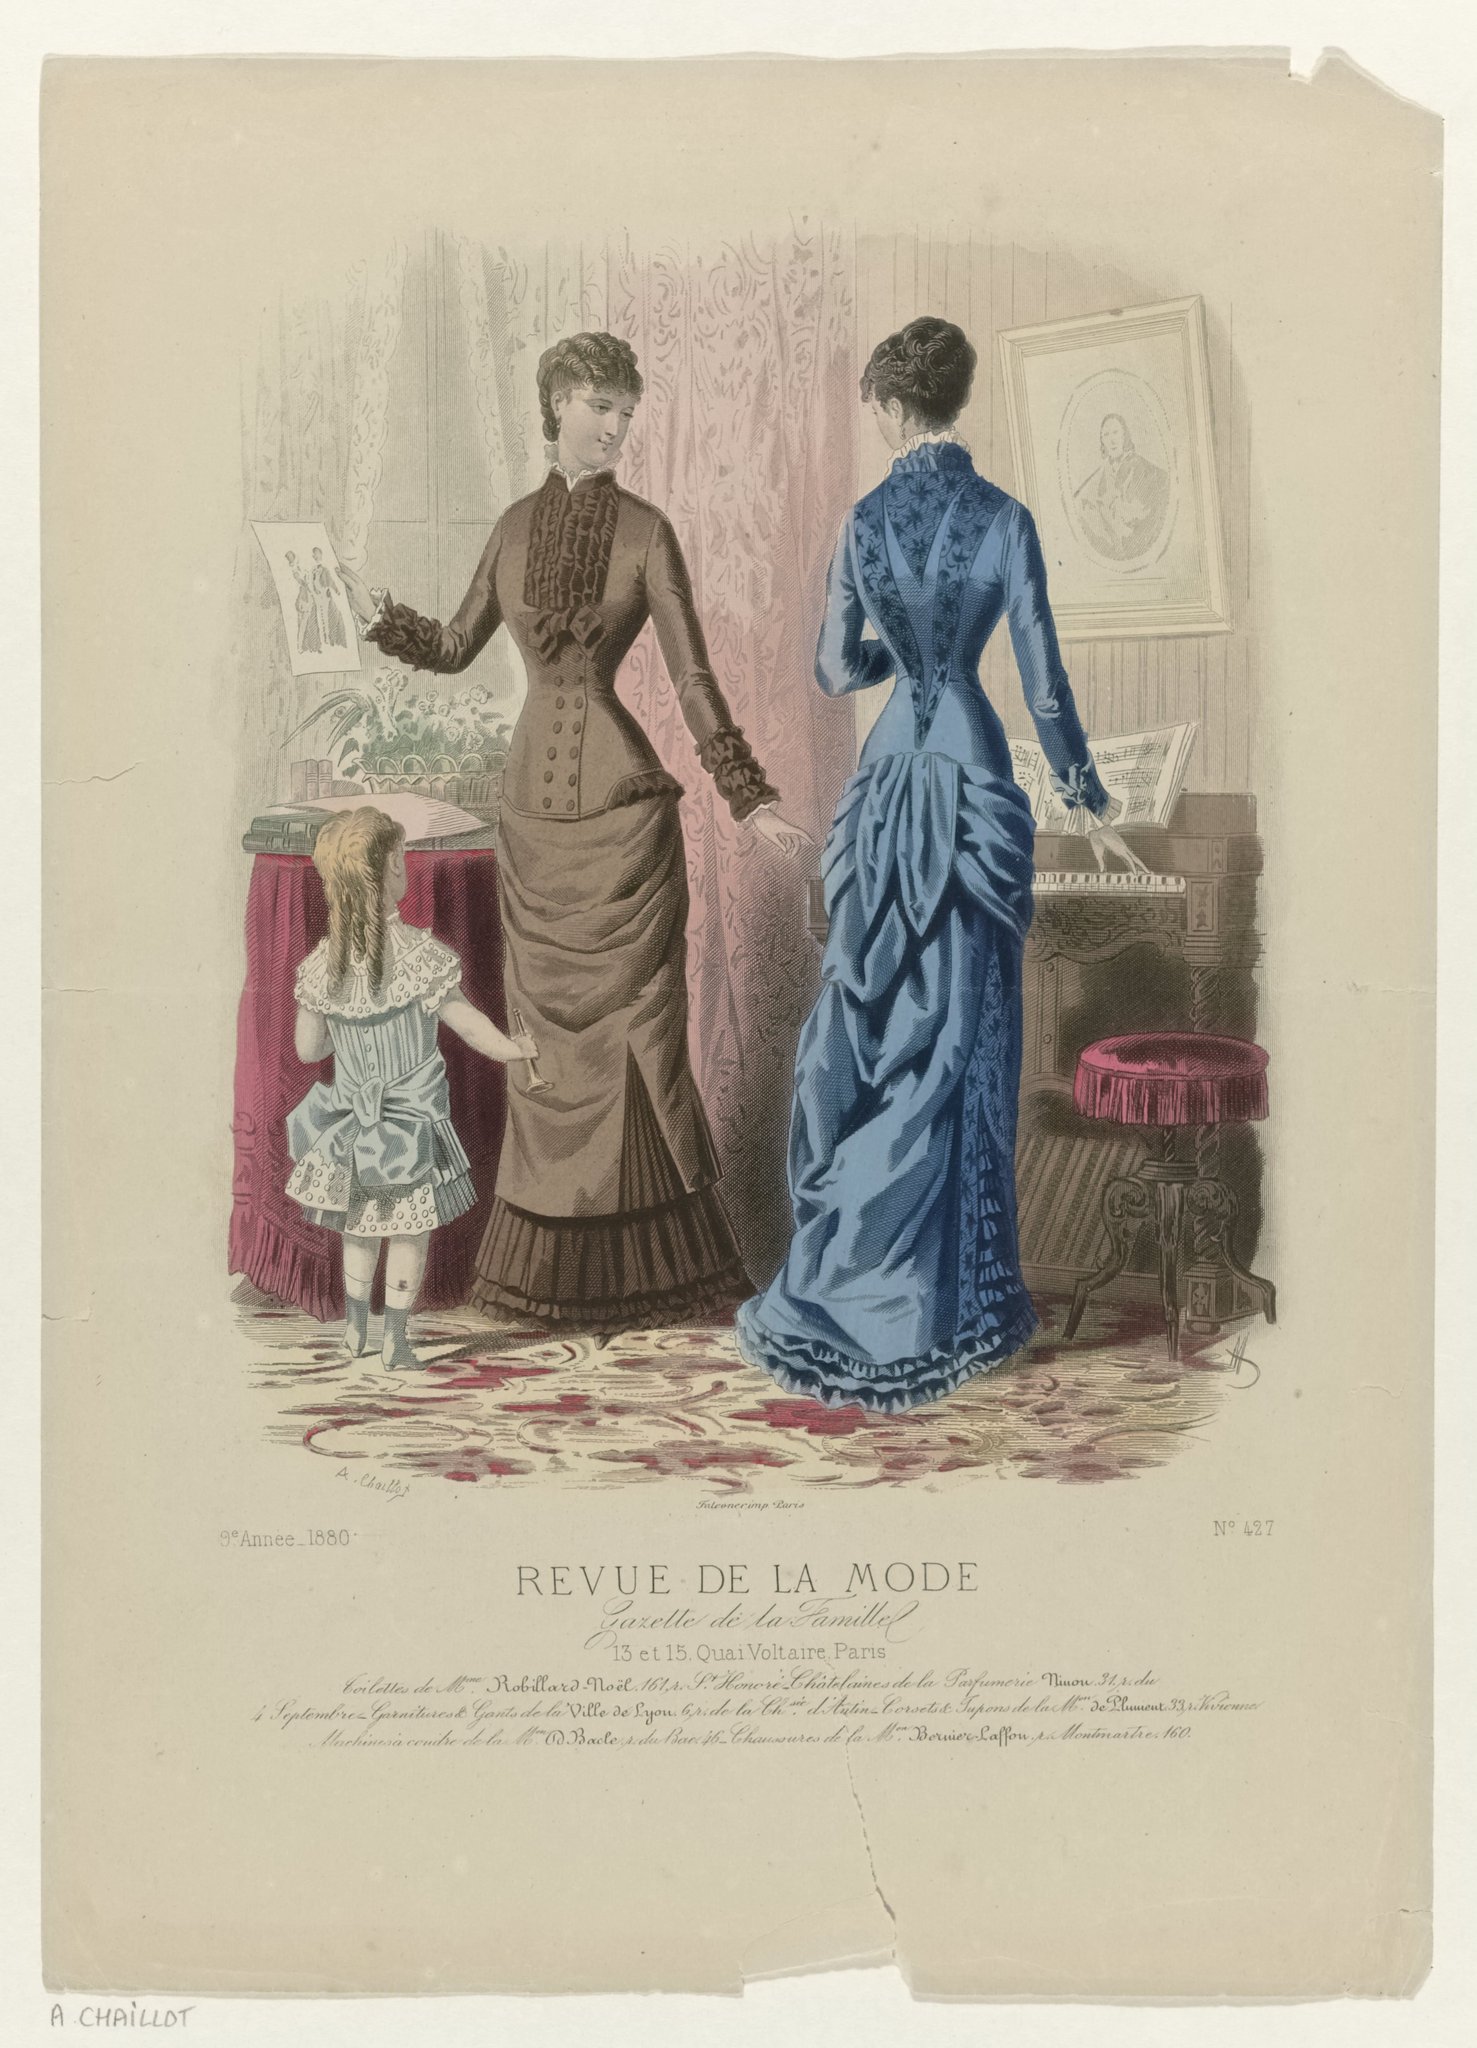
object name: fashion print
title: Revue de la Mode, Gazette de la Famille, dimanche 7 mars 1880, 9e année, No. 427: Toilettes de Mme Robillard-Noël (...)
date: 1880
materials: paper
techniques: engraving, hand coloring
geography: paris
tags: notation of music, dress, gown (robe d'intérieur) (+ women's clothes), horn, trumpet, cornet, trombone, tuba (+ variant), fashion plates, pianoforte, dress, gown (+ girls' clothes)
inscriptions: title: ‘REVUE DE LA MODE / Gazette de la Famille’, caption: ‘Toilettes de Mme Robillard - Noël, 161 r. S.t Honoré_Châtelaines de la Parfumerie Ninon, 31.r. du 4 Septembre_Garnitures & Gants de la Ville de Lyon, 6. r. de la Ch.sée d'Antin _Corsets & Jupons de la M.on de Plument.33.r.Vivienne. Machines à coudre de la M.on D Bacle,r. du Bac 46_Chaussures de la M.on Bernier-Laffon.r. Montmartre. 160.’, address: ‘13 et 15, Quai Voltaire, Paris’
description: Twee vrouwen een meisje in een interieur. De vrouw links houdt een modeprent in de hand, de ander staat bij een piano. Beiden dragen japonnen van Robillard-Noël. Het meisje draagt kinderkleding voor een kind van drie tot vier jaar oud van het 'English Warehouse'. Midden: bruin kostuum van kasjmier ('cachemire d'Ecosse') en satijn, voor de paardenraces, 'visites', 'intérieur'. Rechts: blauwe 'Robe d'interieur et de visites' van wol en satijn ('lainage satin' ) en fluweel. Onder de voorstelling enkele regels reclametekst voor verschillende producten. Prent uit het modetijdschrift Revue de la Mode (1872-1913). Uitgebreide beschrijving van de kleding op pagina 85 en 86 "PLANCHE COLORIÉE".